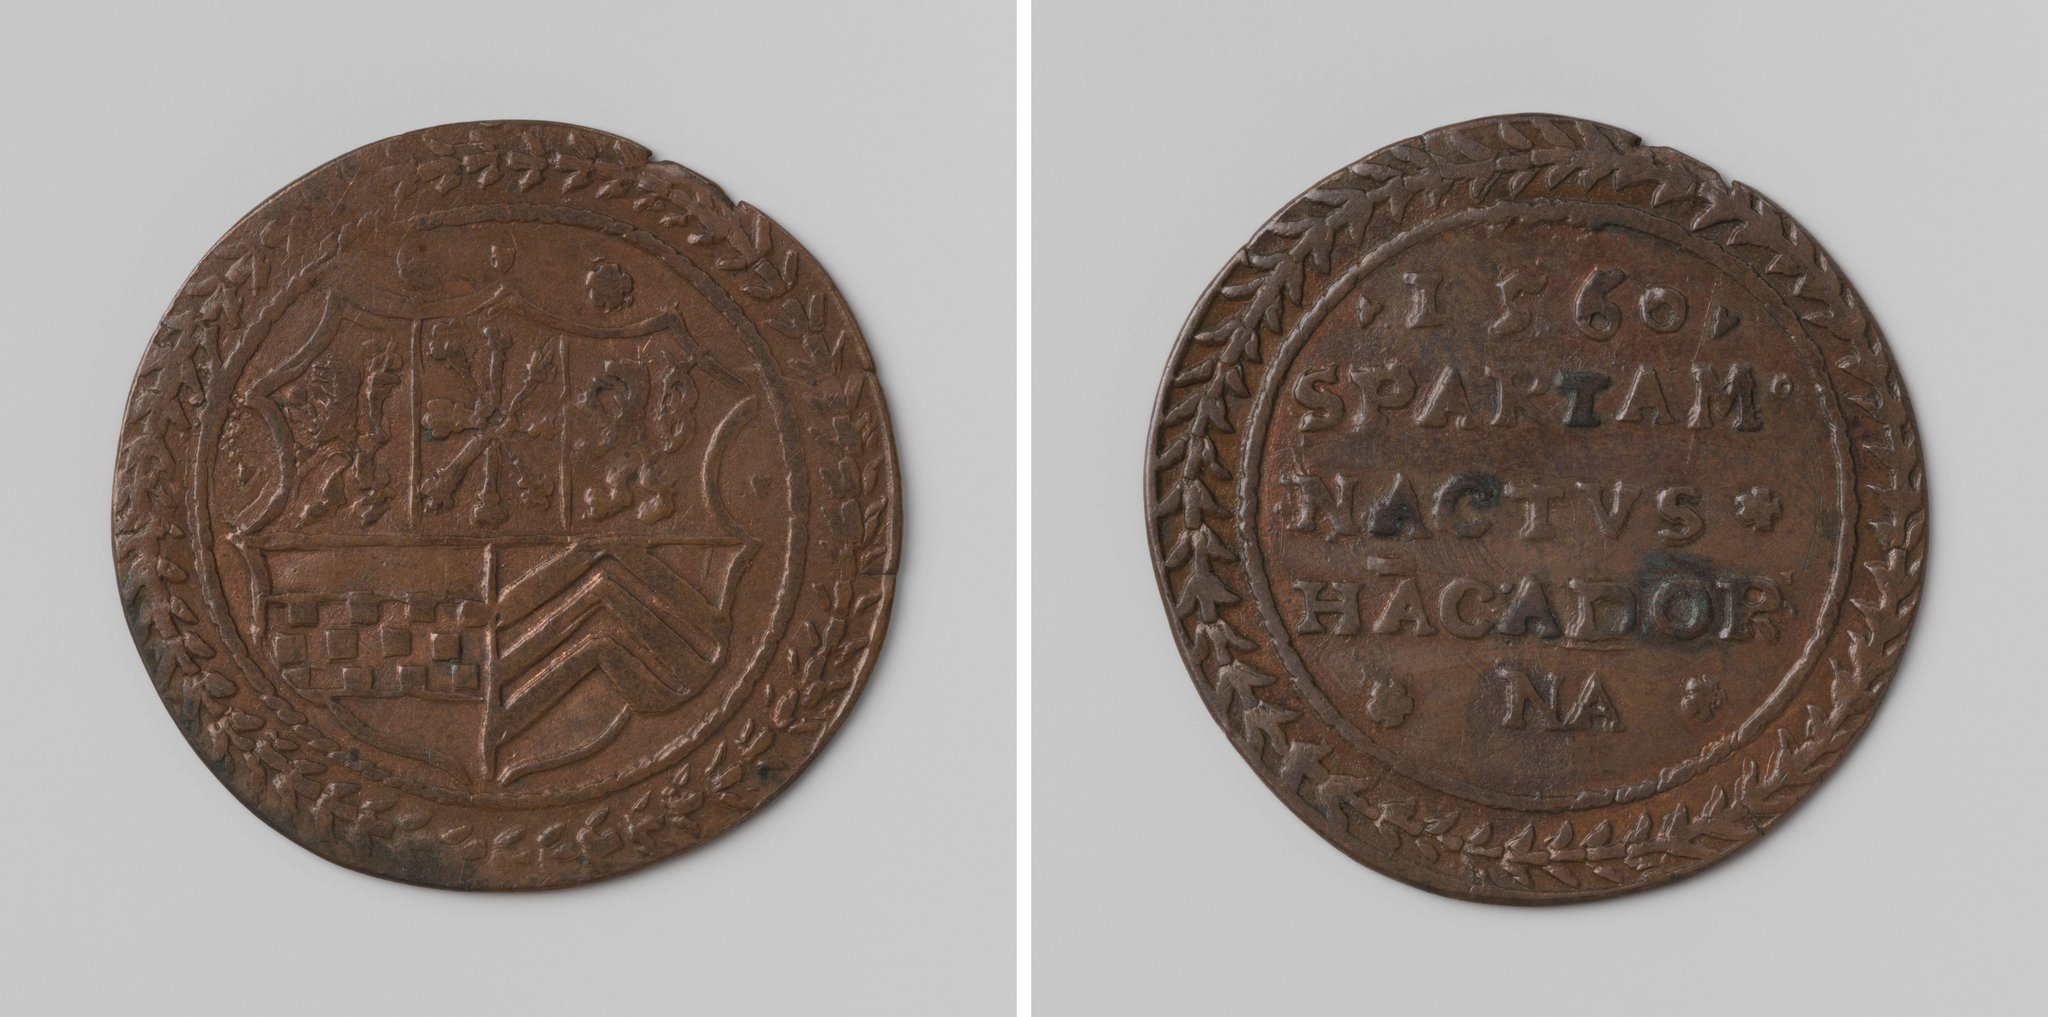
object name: jeton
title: Willem II, hertog van Gulik en Kleef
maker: Anonymous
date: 1560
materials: copper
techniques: striking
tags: willem ii (hertog van gelre)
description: Koperen penning. Voorzijde: wapenschild binnen lauwerkrans. Keerzijde: opschrift binnen lauwerkrans